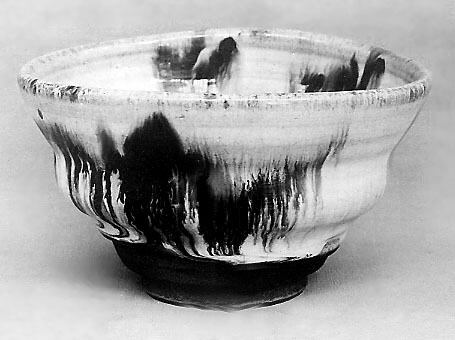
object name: bowl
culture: japanese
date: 1801-1900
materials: clay, glaze